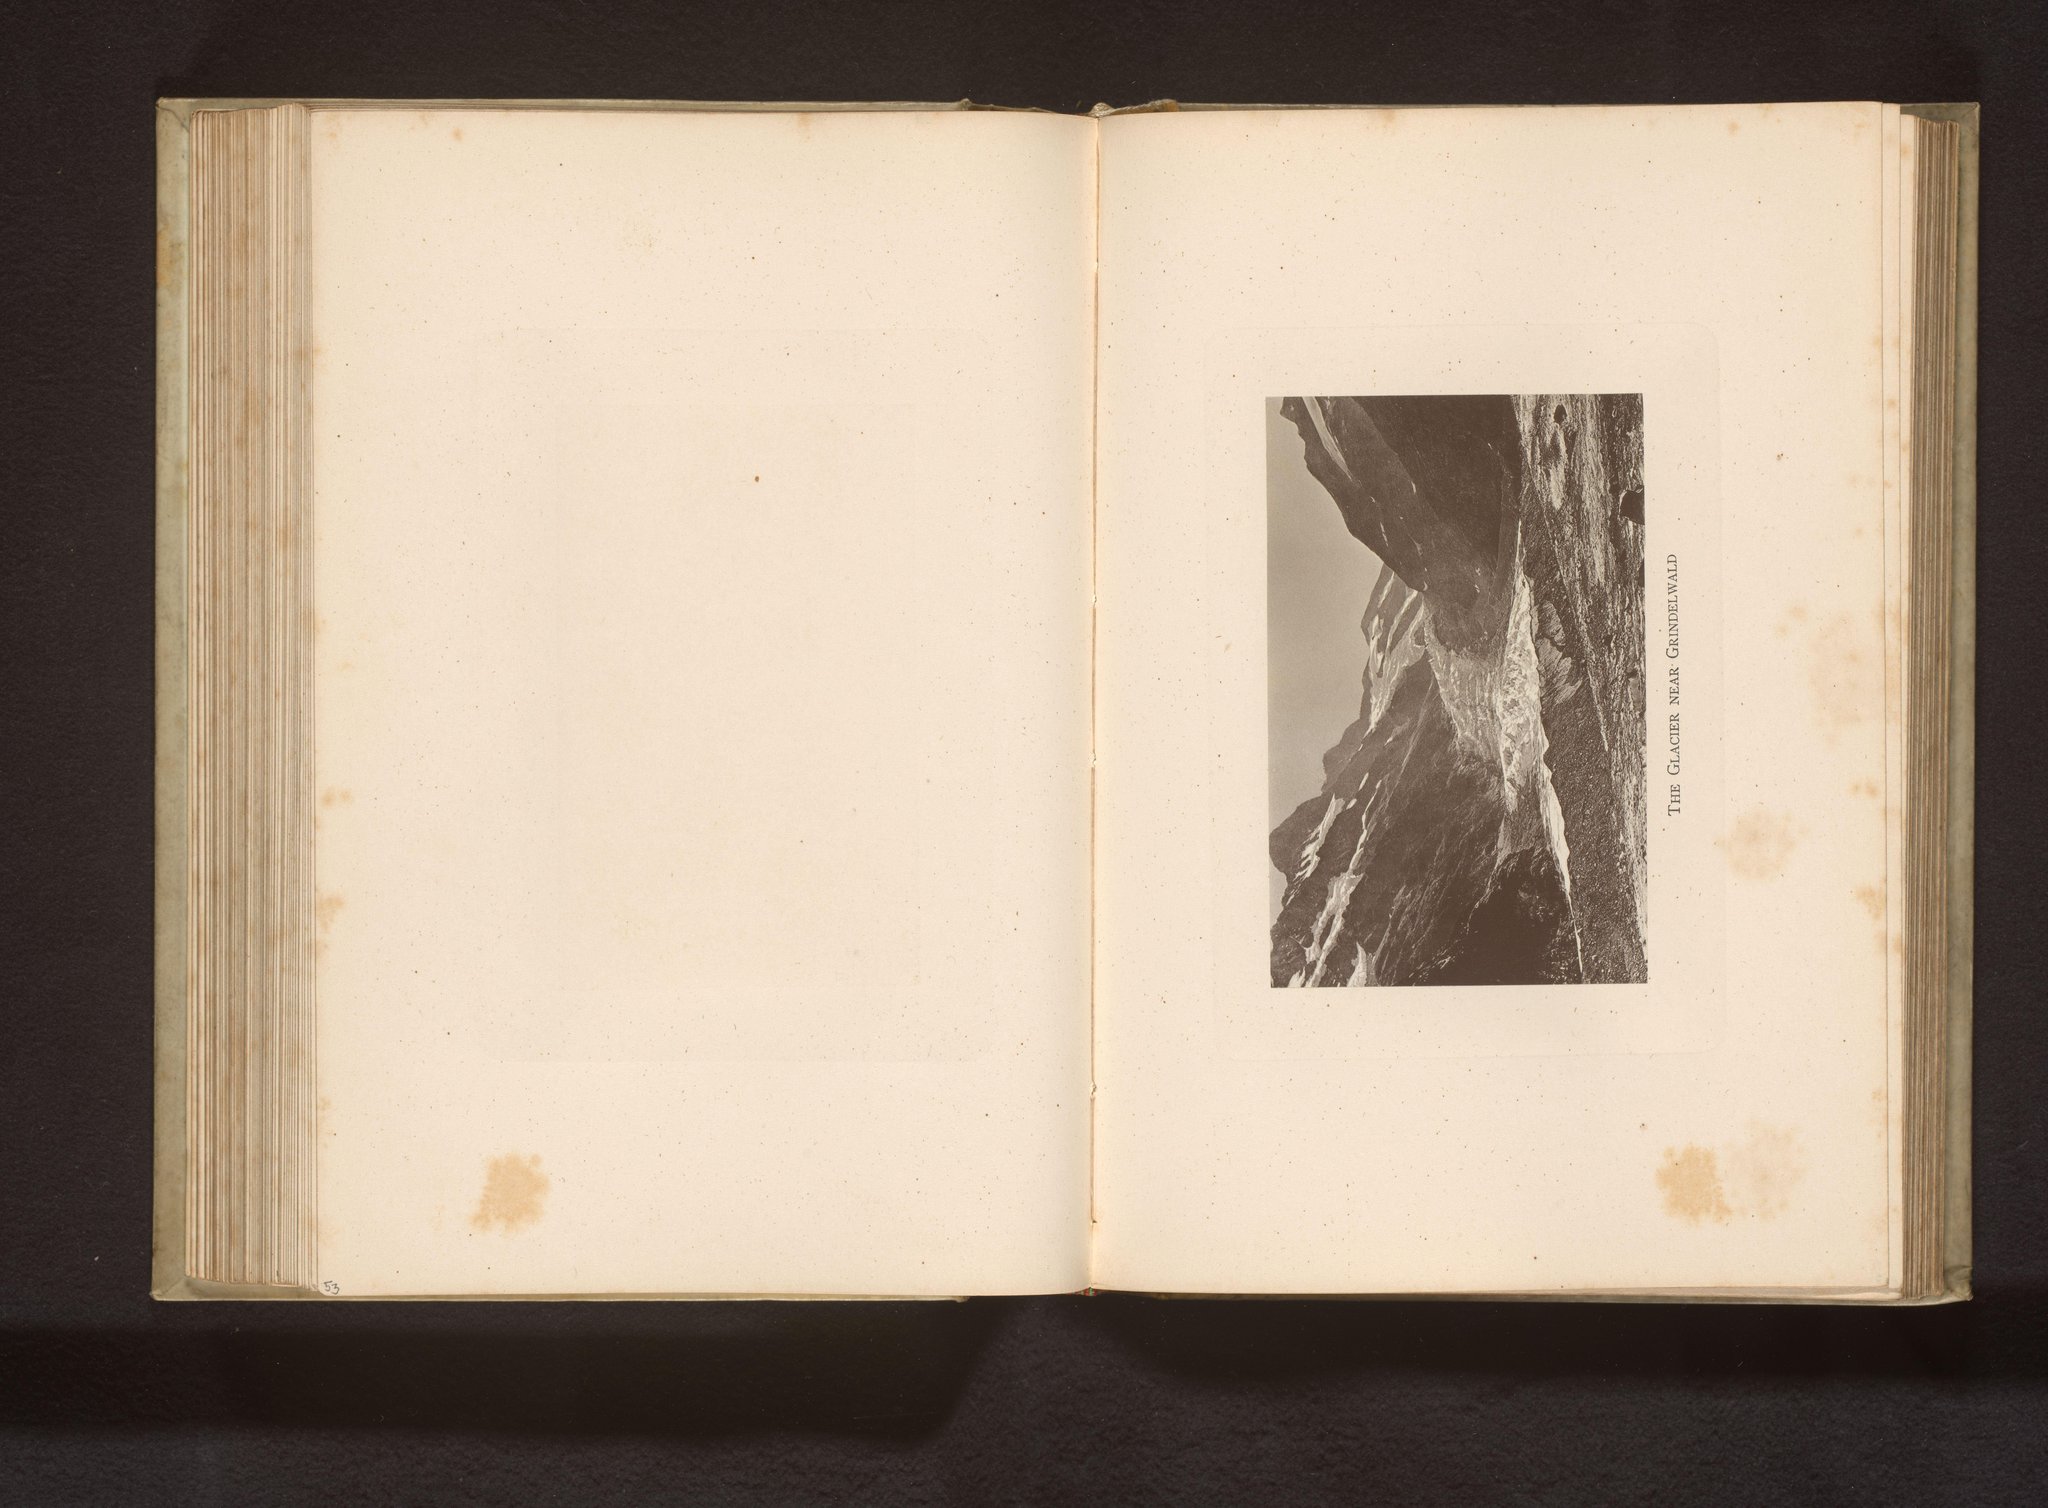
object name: photomechanical print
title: The glacier near Grindelwald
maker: Anonymous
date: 1874-1884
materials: paper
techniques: photograph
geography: bern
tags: glacier